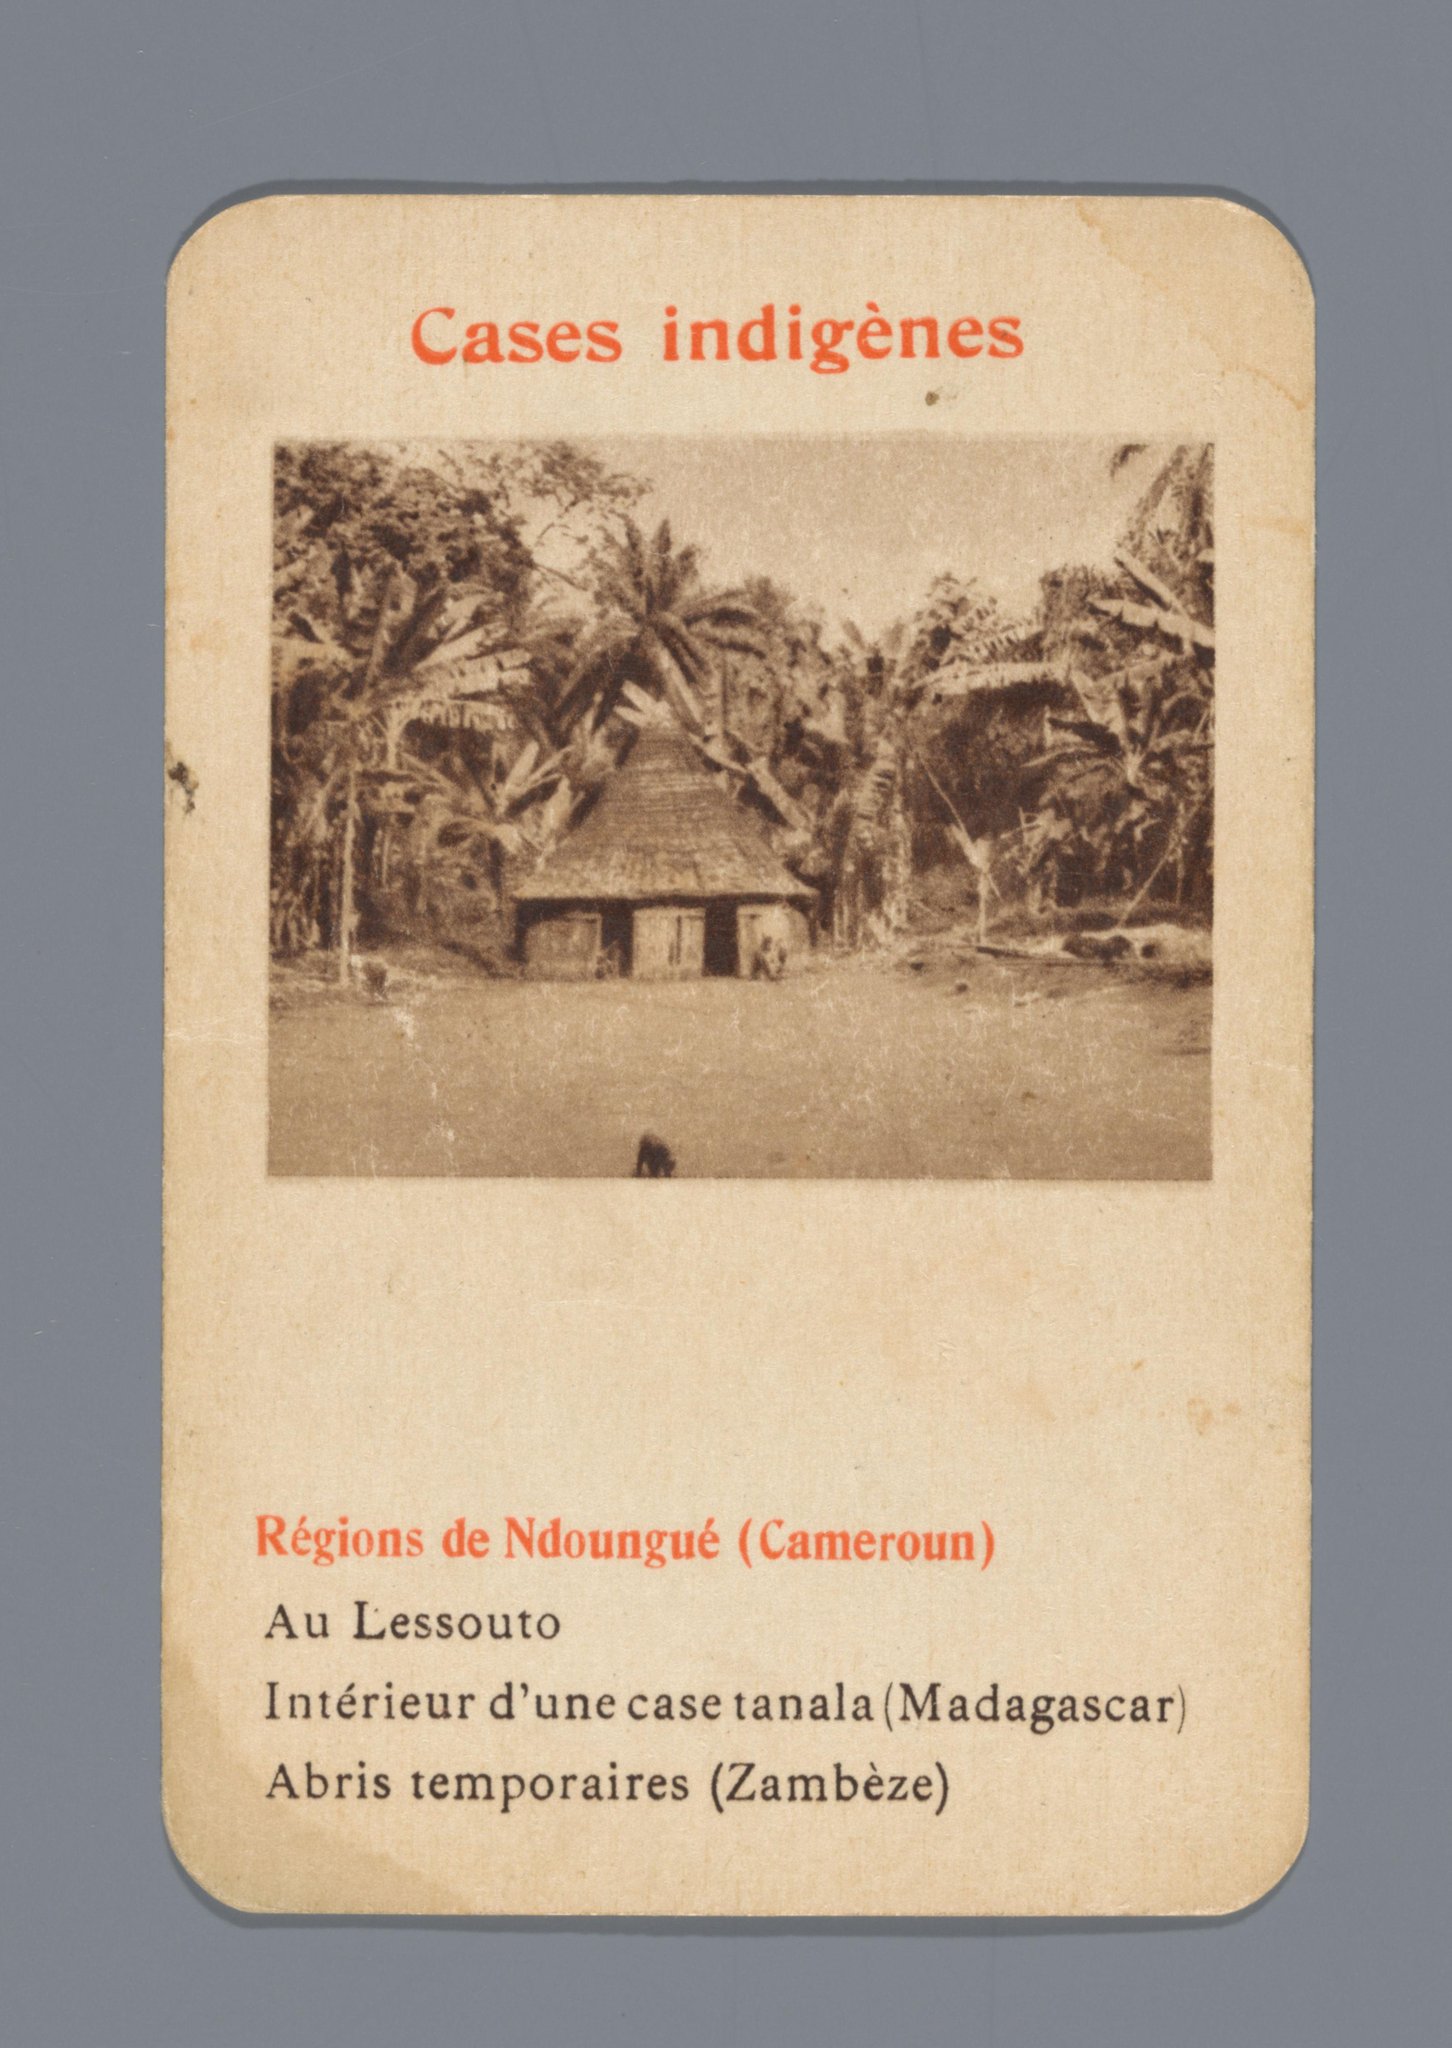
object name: card game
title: Gezicht op een huis te Ndoungué, Kameroen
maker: Anonymous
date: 1900-1920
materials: cardboard, paper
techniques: rotogravure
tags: rural housing, e.g. country-house, villa, cottage, card games